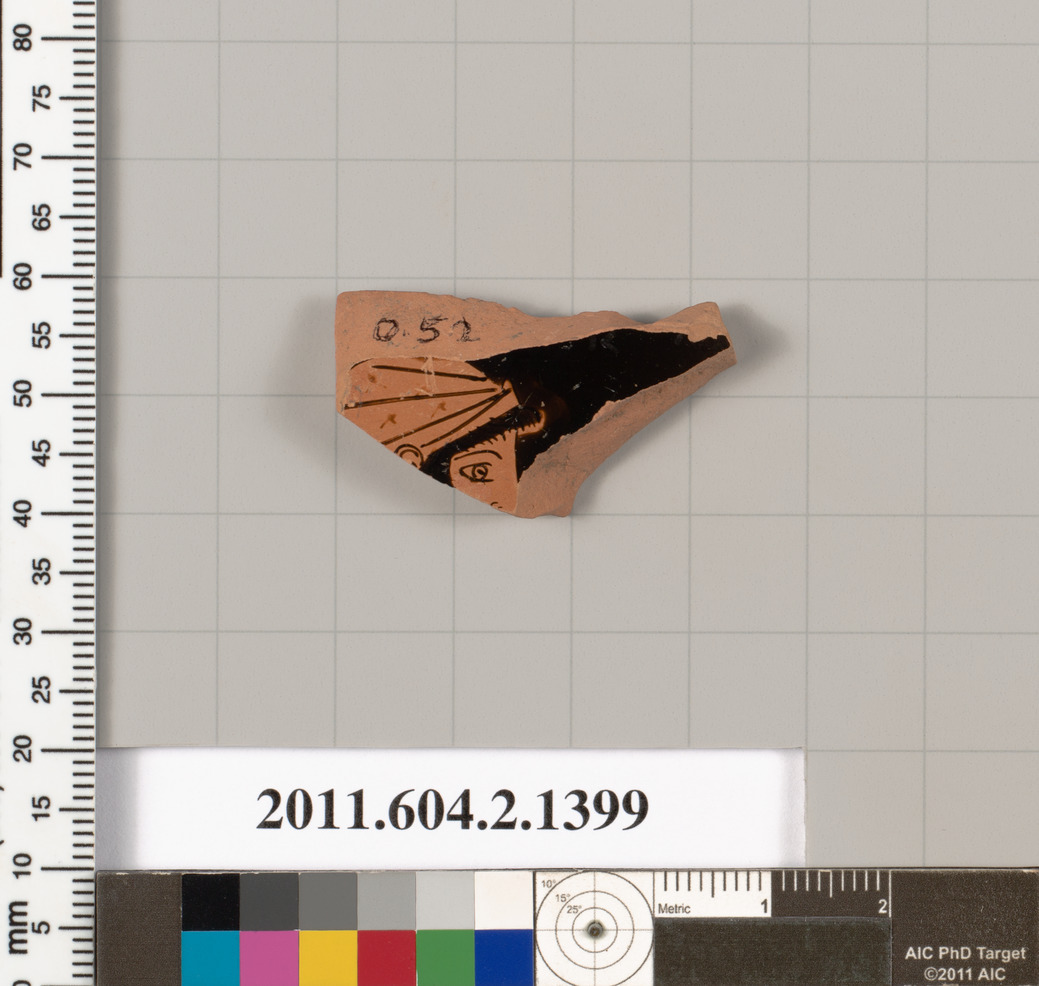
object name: skyphos fragment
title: Terracotta fragment of a skyphos (deep drinking cup)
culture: greek, attic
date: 500-490 BCE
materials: terracotta